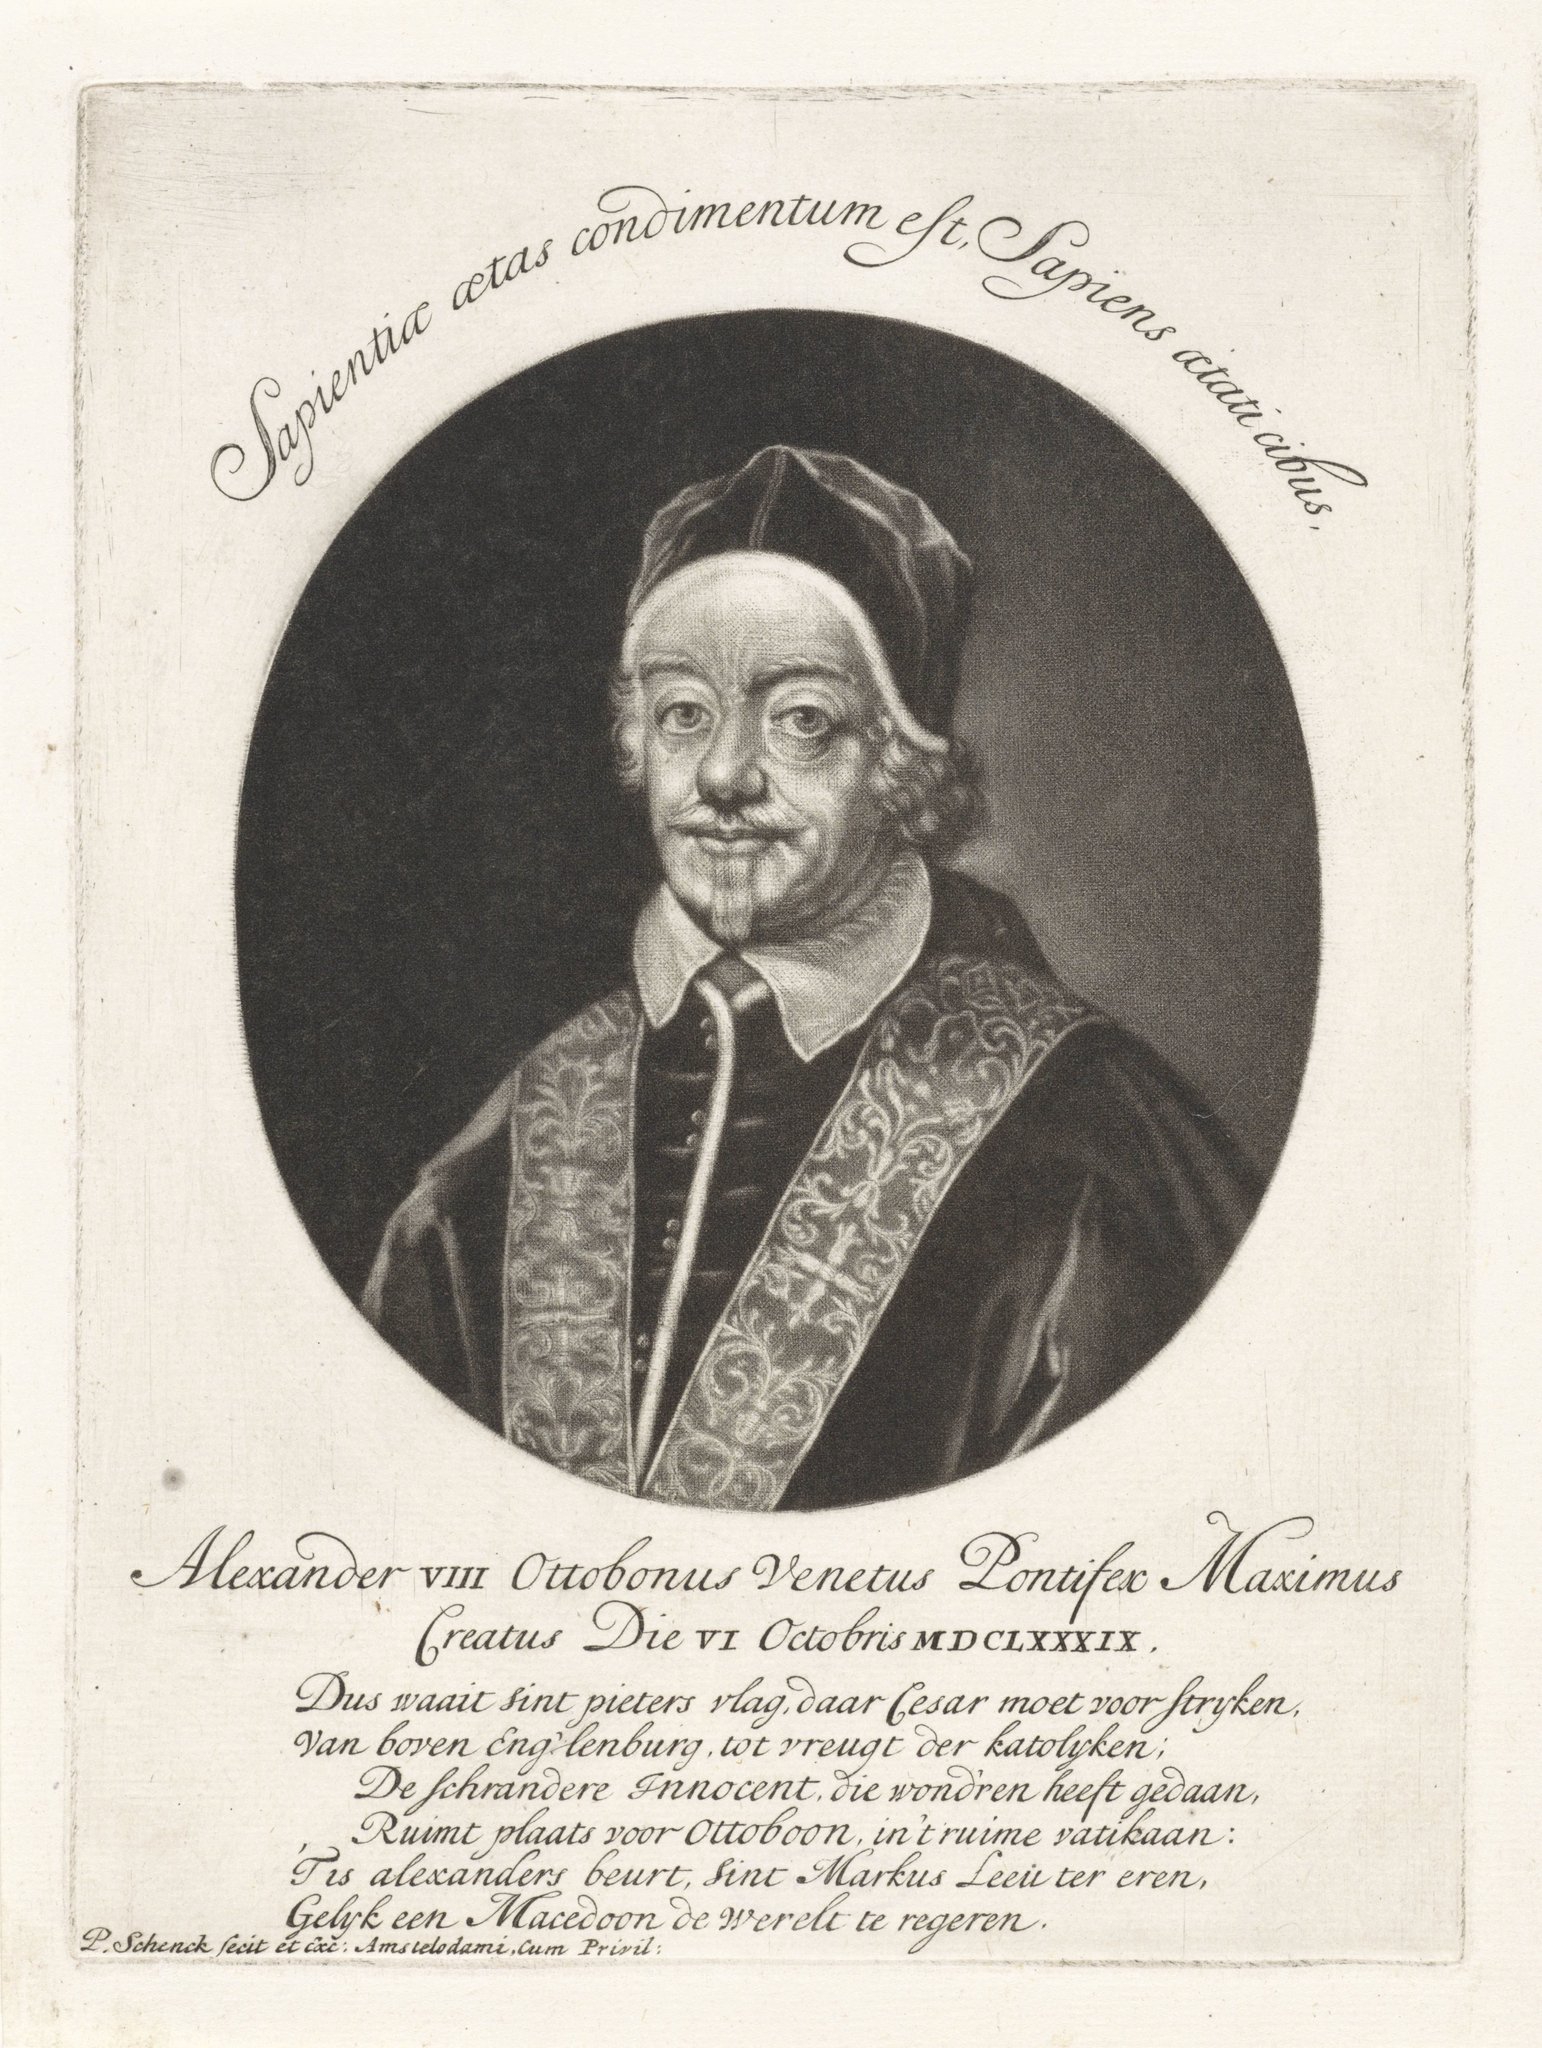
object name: print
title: Portret van paus Alexander VIII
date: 1689-1713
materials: paper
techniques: engraving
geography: amsterdam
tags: clergyman, alexander viii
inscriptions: collector's mark: Lugt 2228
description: Paus Alexander VIII, gehuld in een pauselijk gewaad.